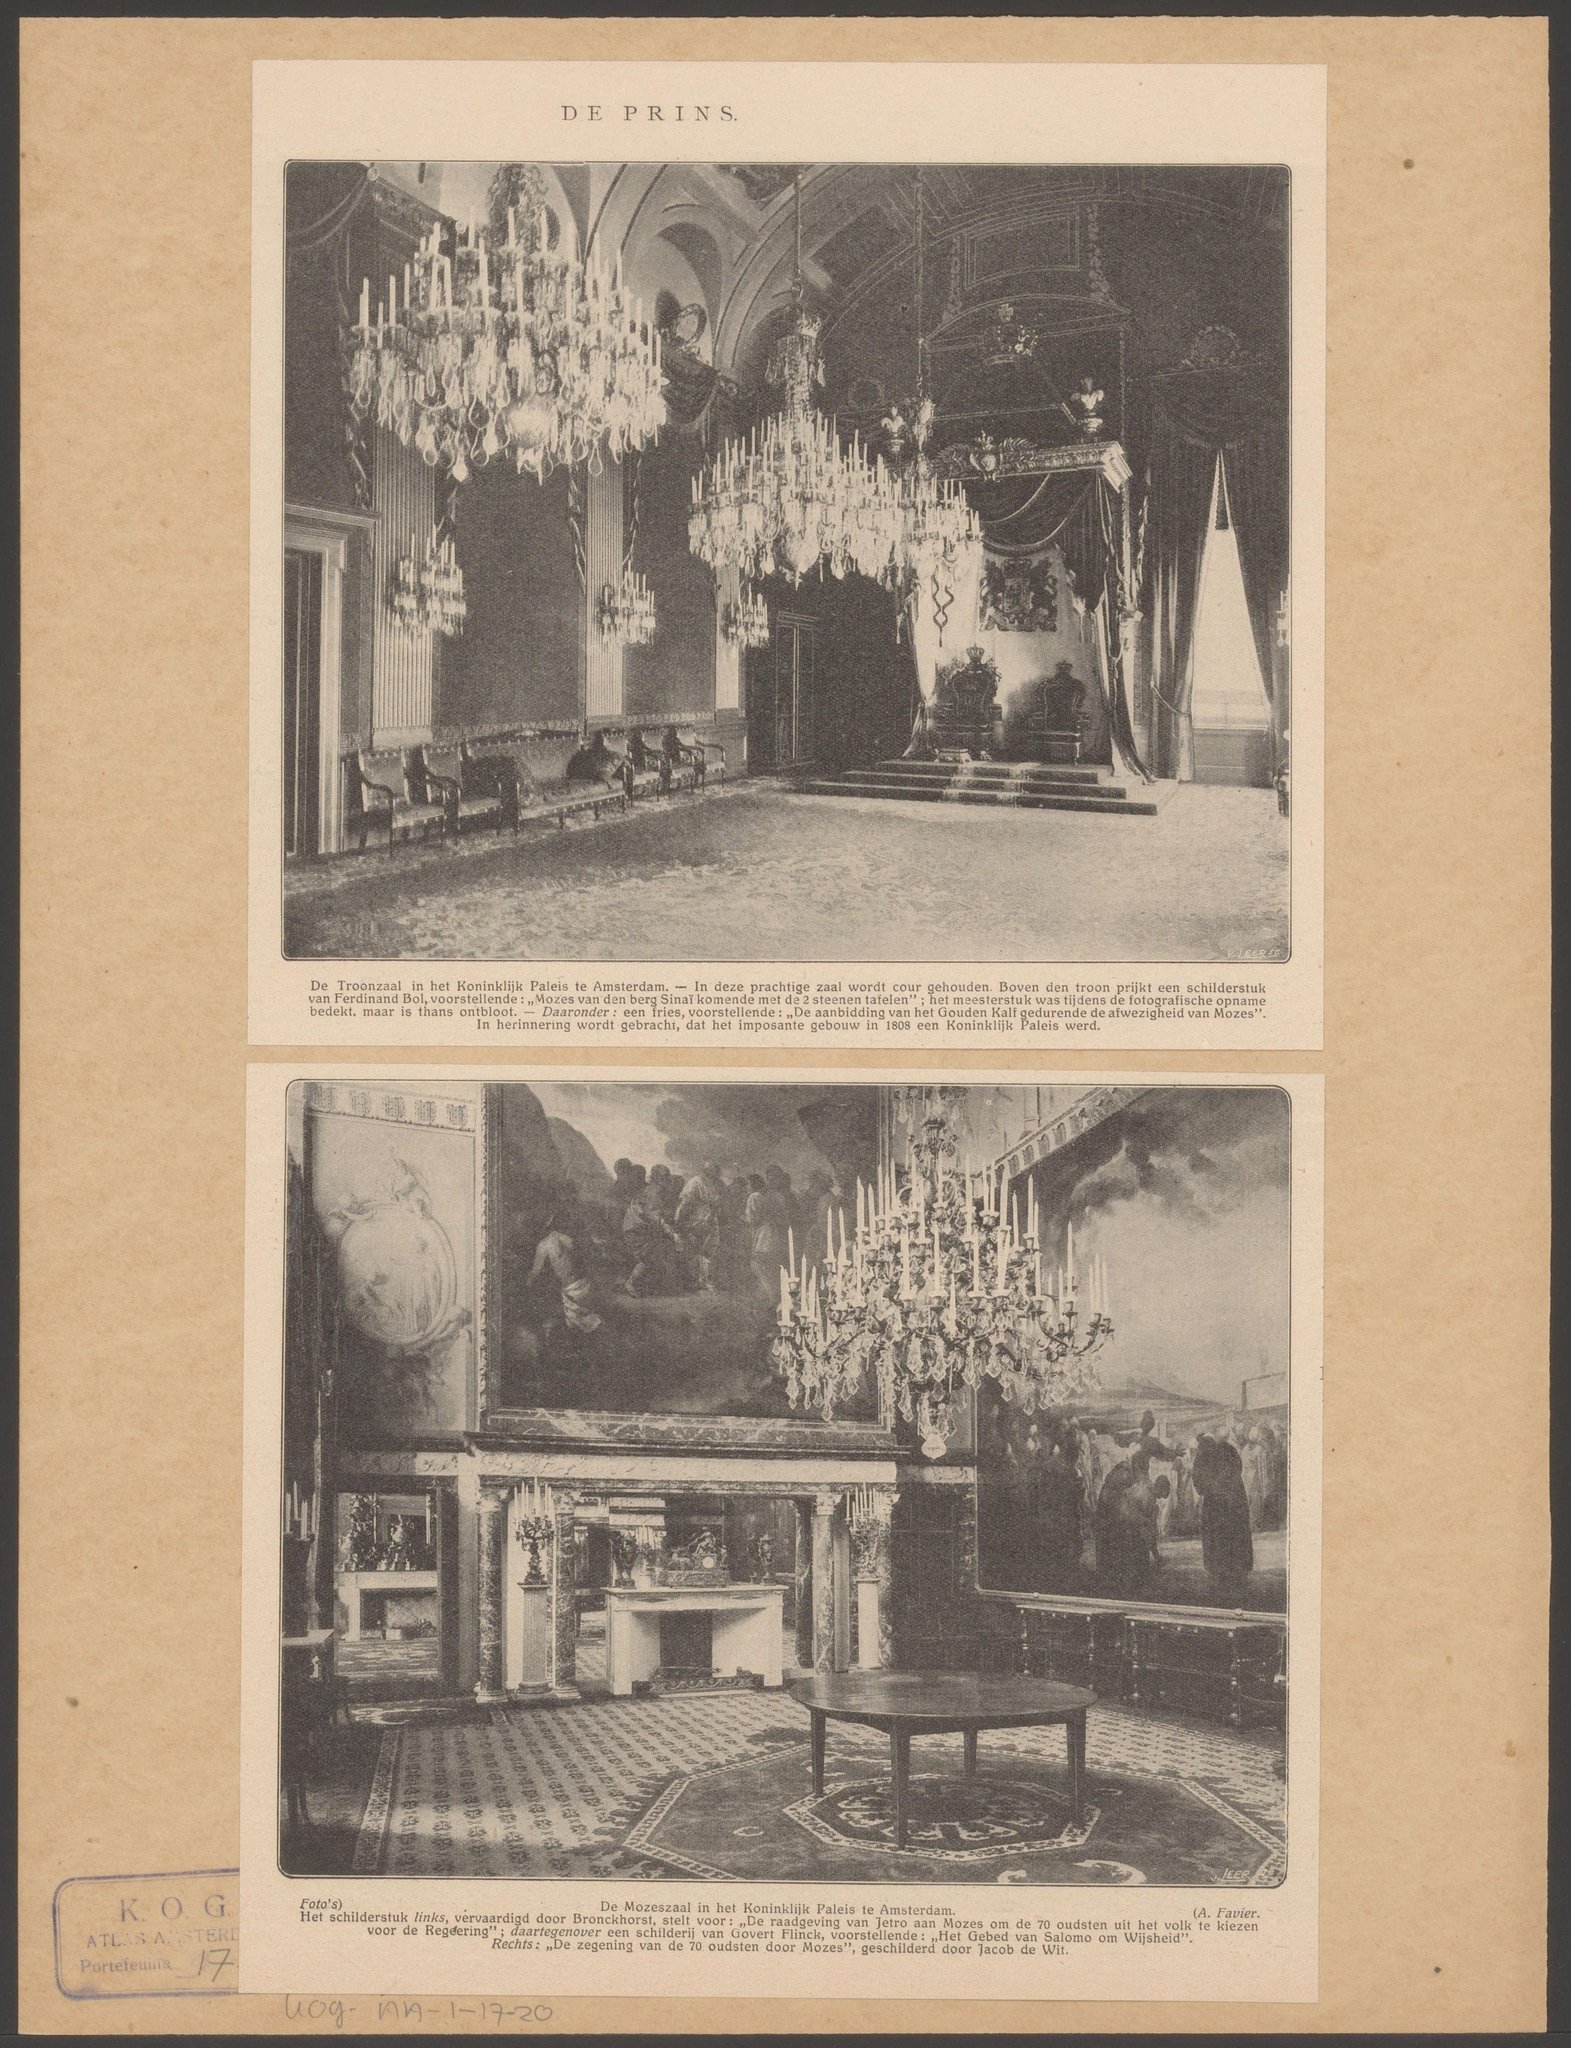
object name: photomechanical print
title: Gezicht op de Troonzaal en de Mozeszaal in het Paleis op de Dam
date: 1901-1948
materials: paper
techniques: letterpress printing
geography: amsterdam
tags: townhall, royal palace of amsterdam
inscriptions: collector's mark: ‘17 20AB’ Lugt 1641b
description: Onderwerpsrubriek binnen de Atlas Amsterdam: Nieuwe Stadhuis, van binnen: Groote zaal, Raadkamer, Schepenkamer, Troonzaal, Mozeszaal, Zitkamer.